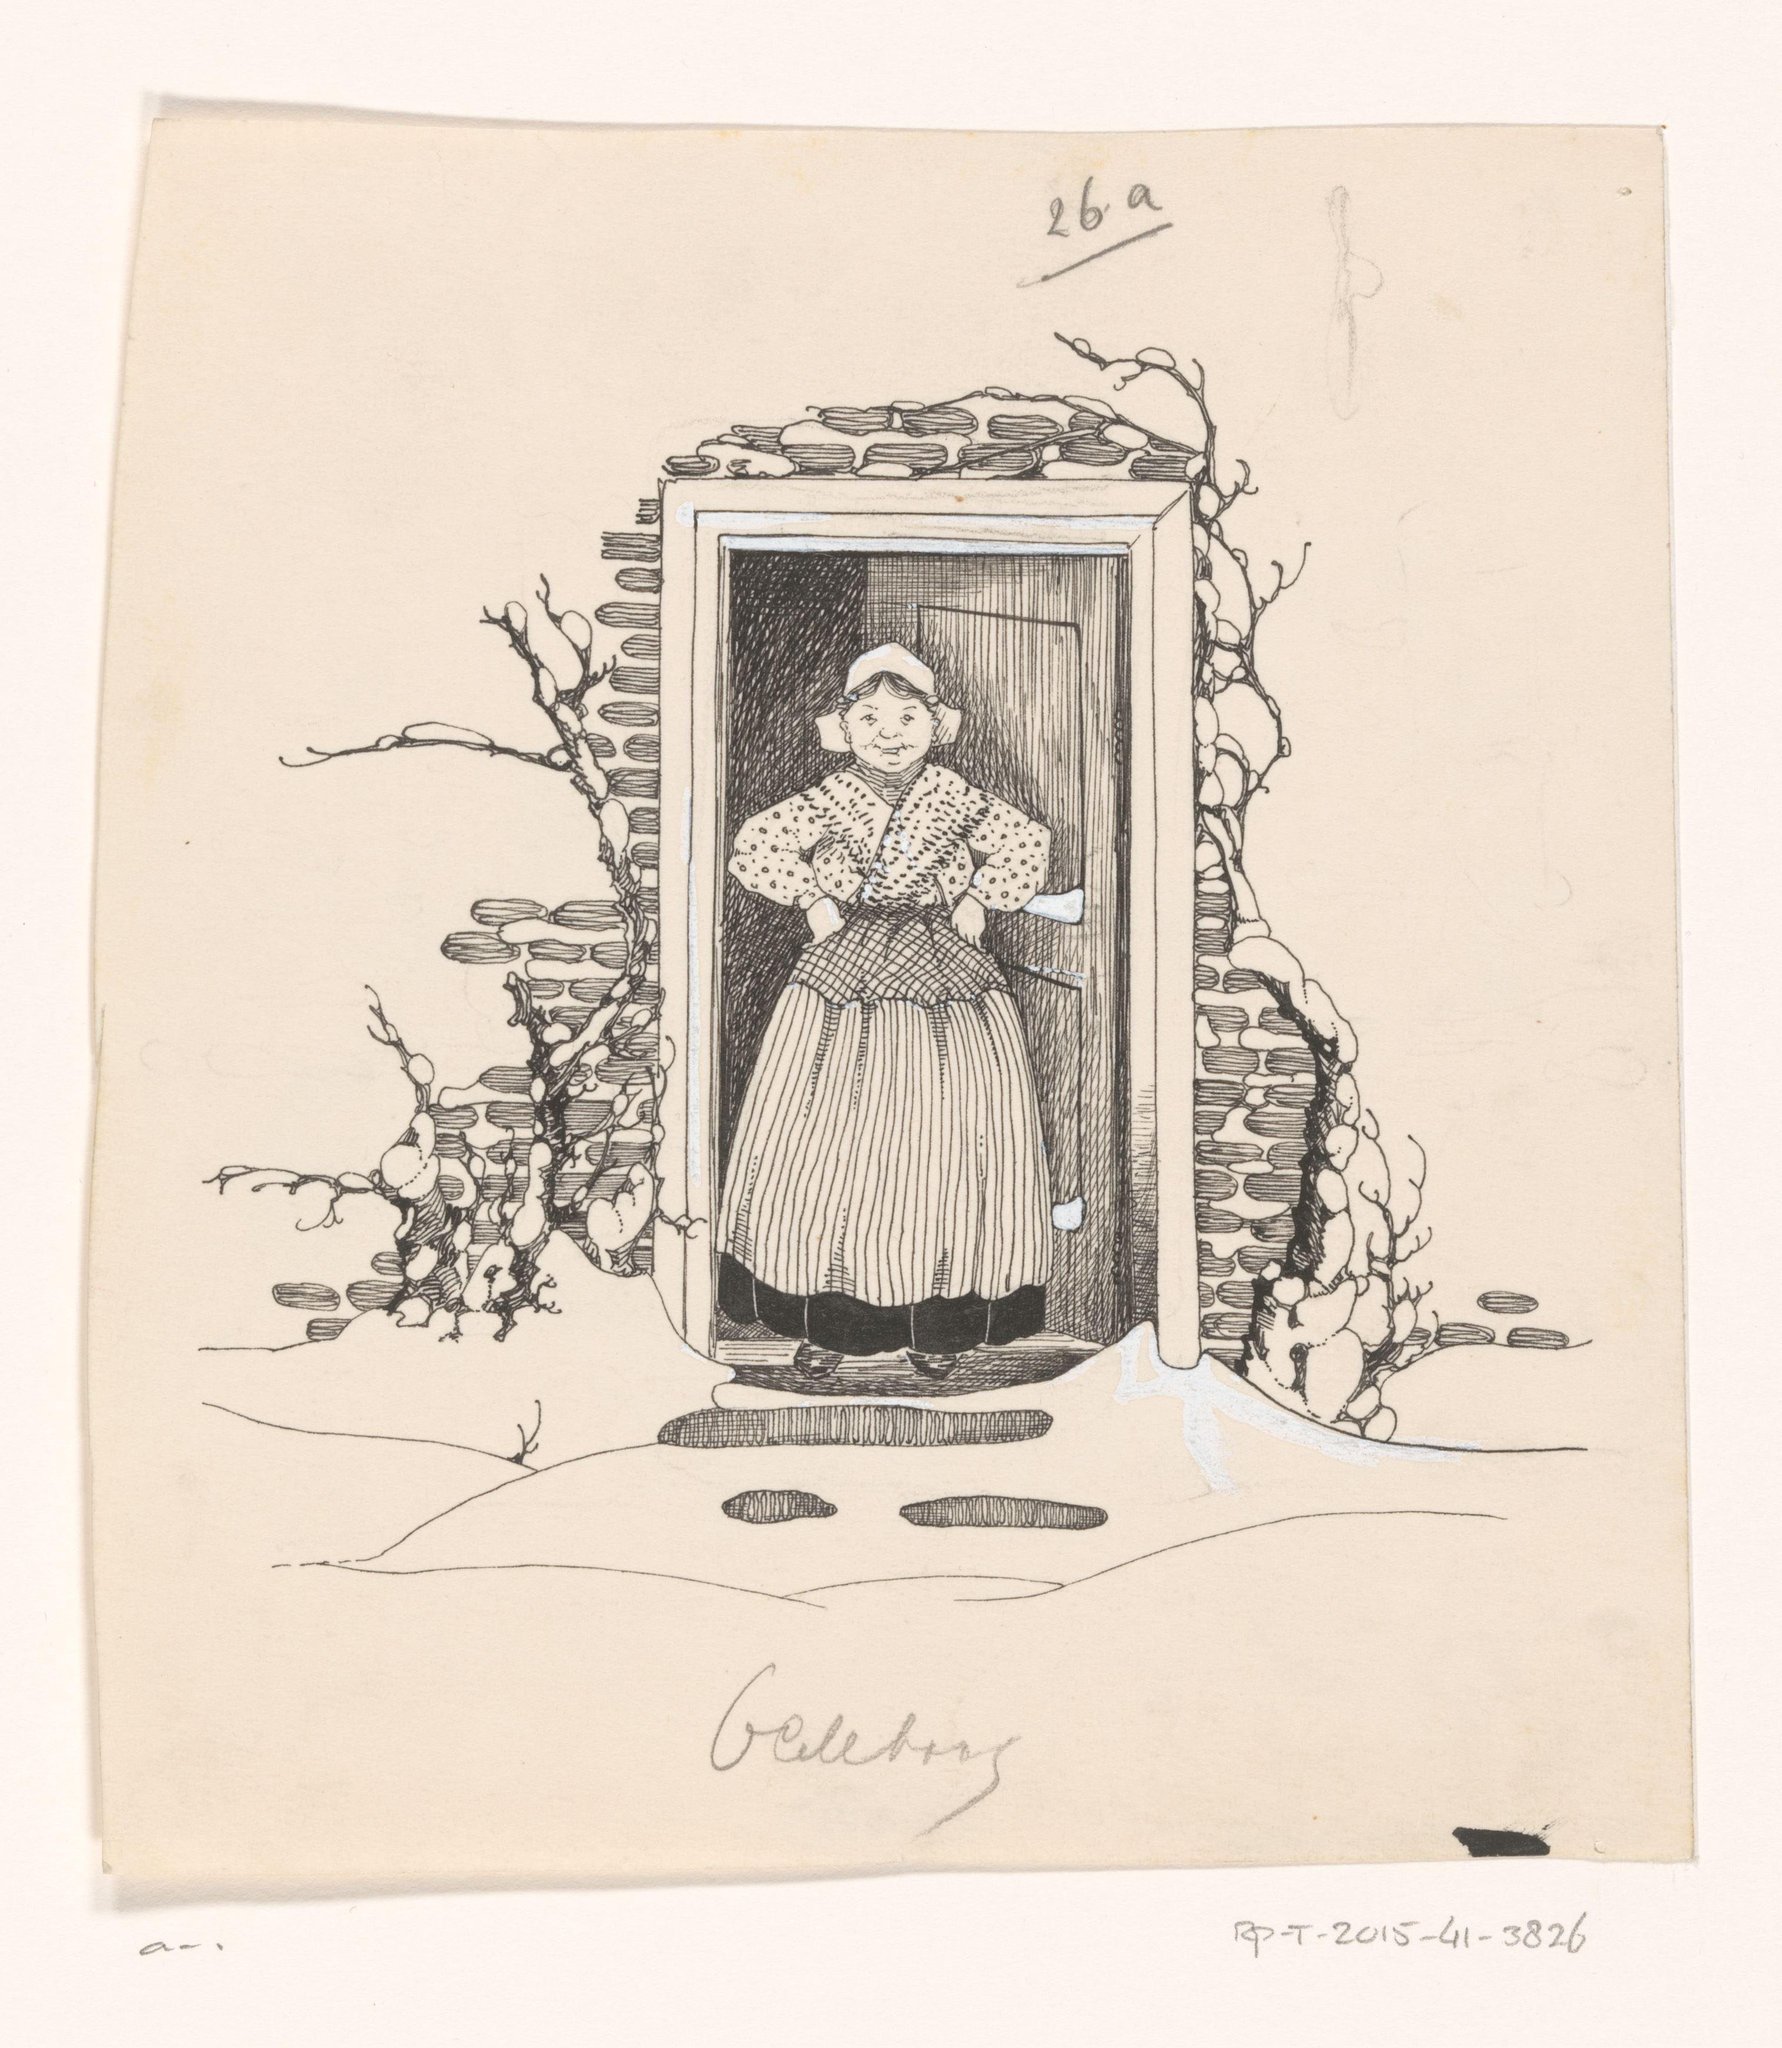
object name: boekillustratie ontwerp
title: Vrouw in klederdracht in een deuropening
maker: Anonymous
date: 1890-1930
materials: paint, ink, paper, pencil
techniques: brush, pen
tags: open door, folk costume, regional costume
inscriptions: :, number: ‘26a’, collector's mark: Lugt 2228a